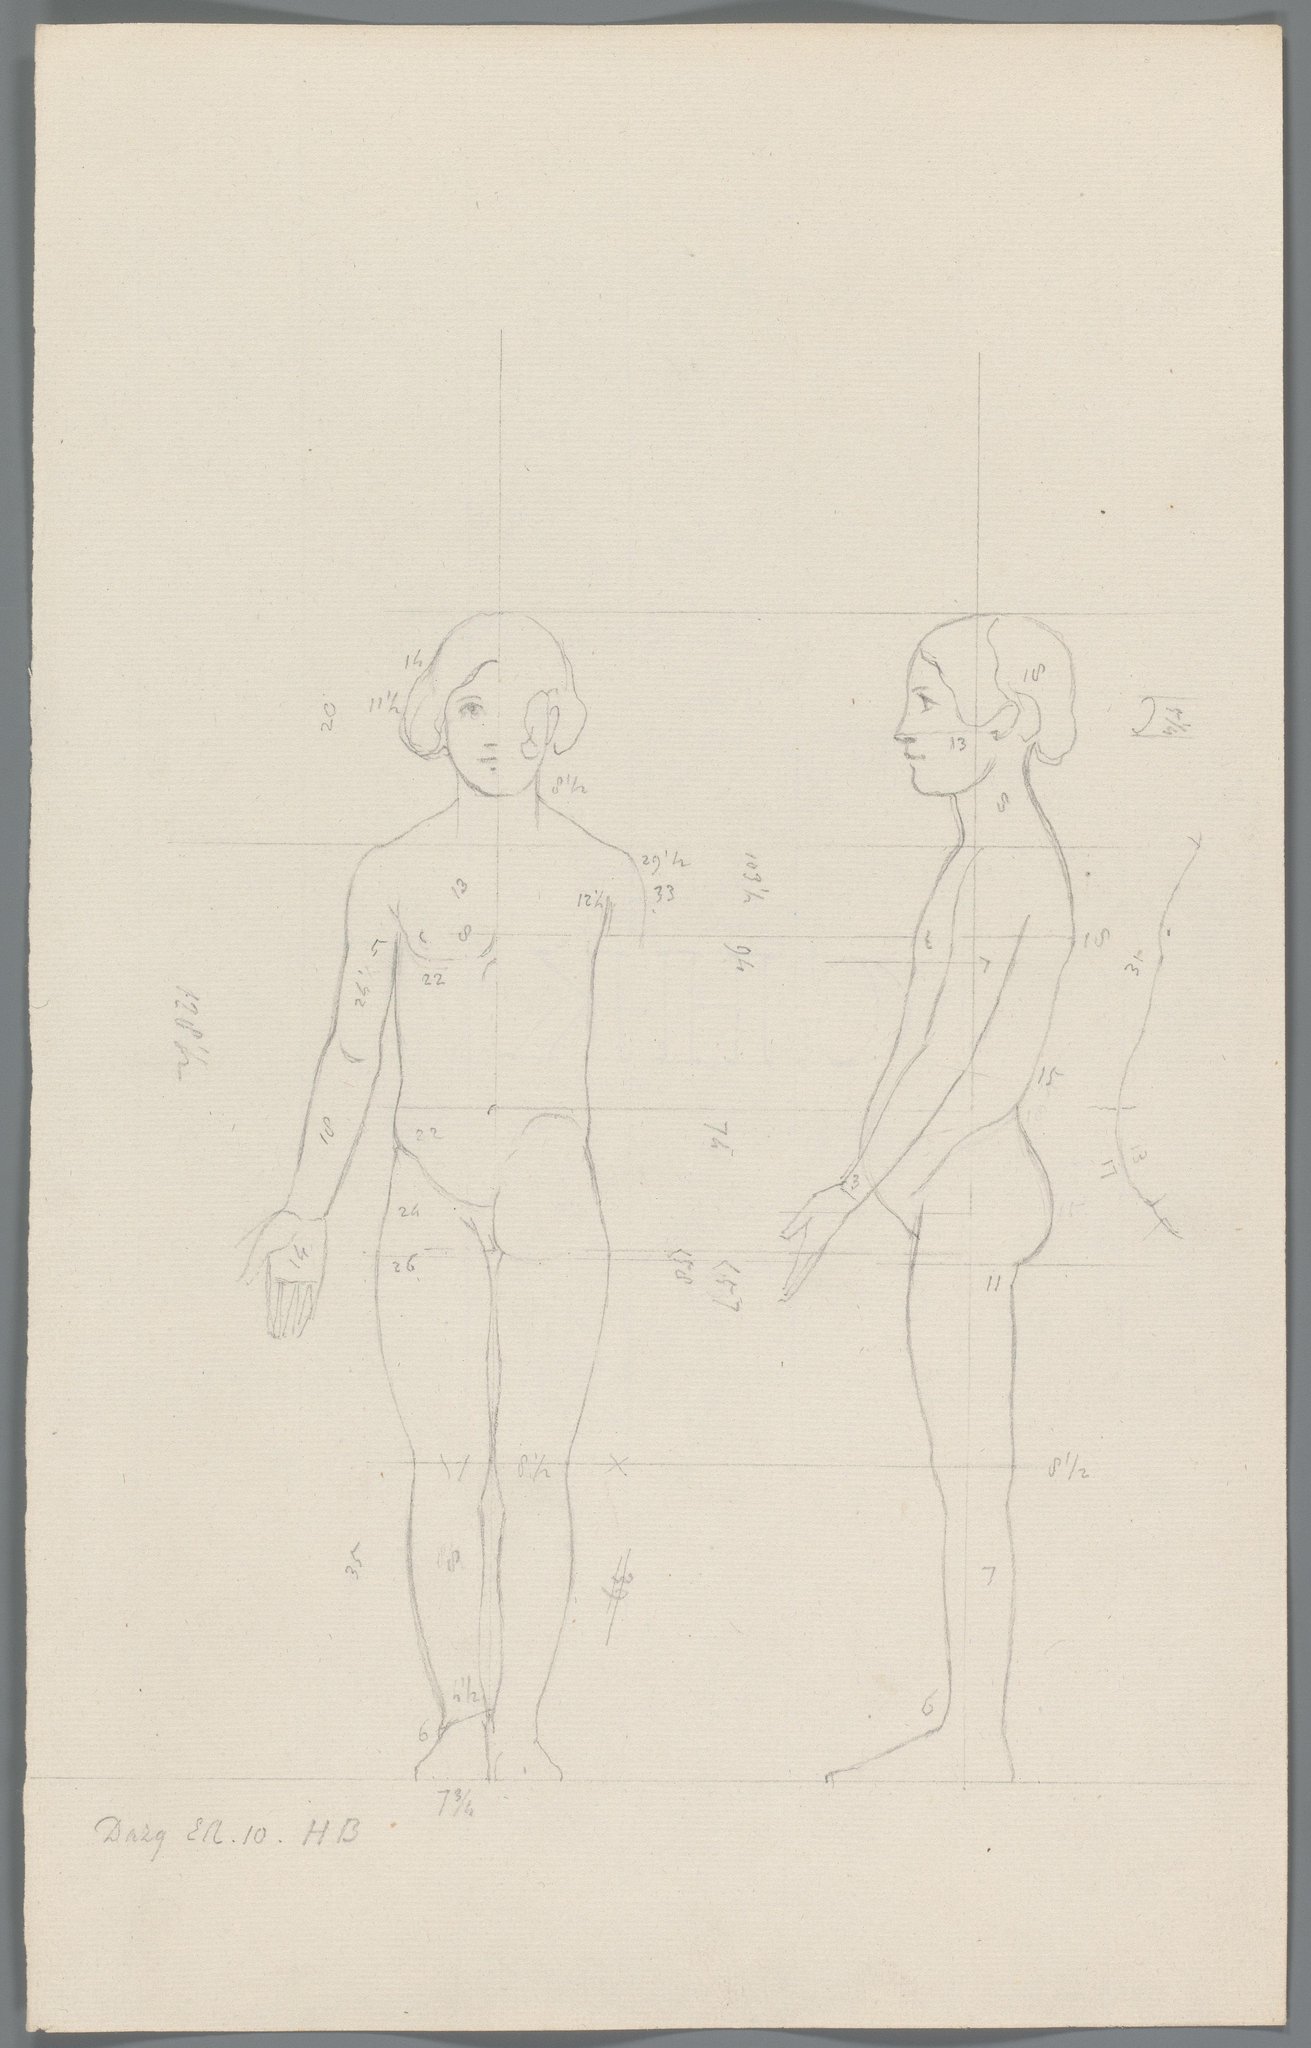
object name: drawing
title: Proportiestudie van een meisje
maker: jacobus everhardus josephus van den berg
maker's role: draughtsman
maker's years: 1802-1861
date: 1851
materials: paper, pencil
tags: standing figure (canon, proportions) - aa - female human figure, anatomy (non-medical) - aa - female human figure, child (at home) - aa - girl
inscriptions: inscription: ‘Darg EA 10 HB.’